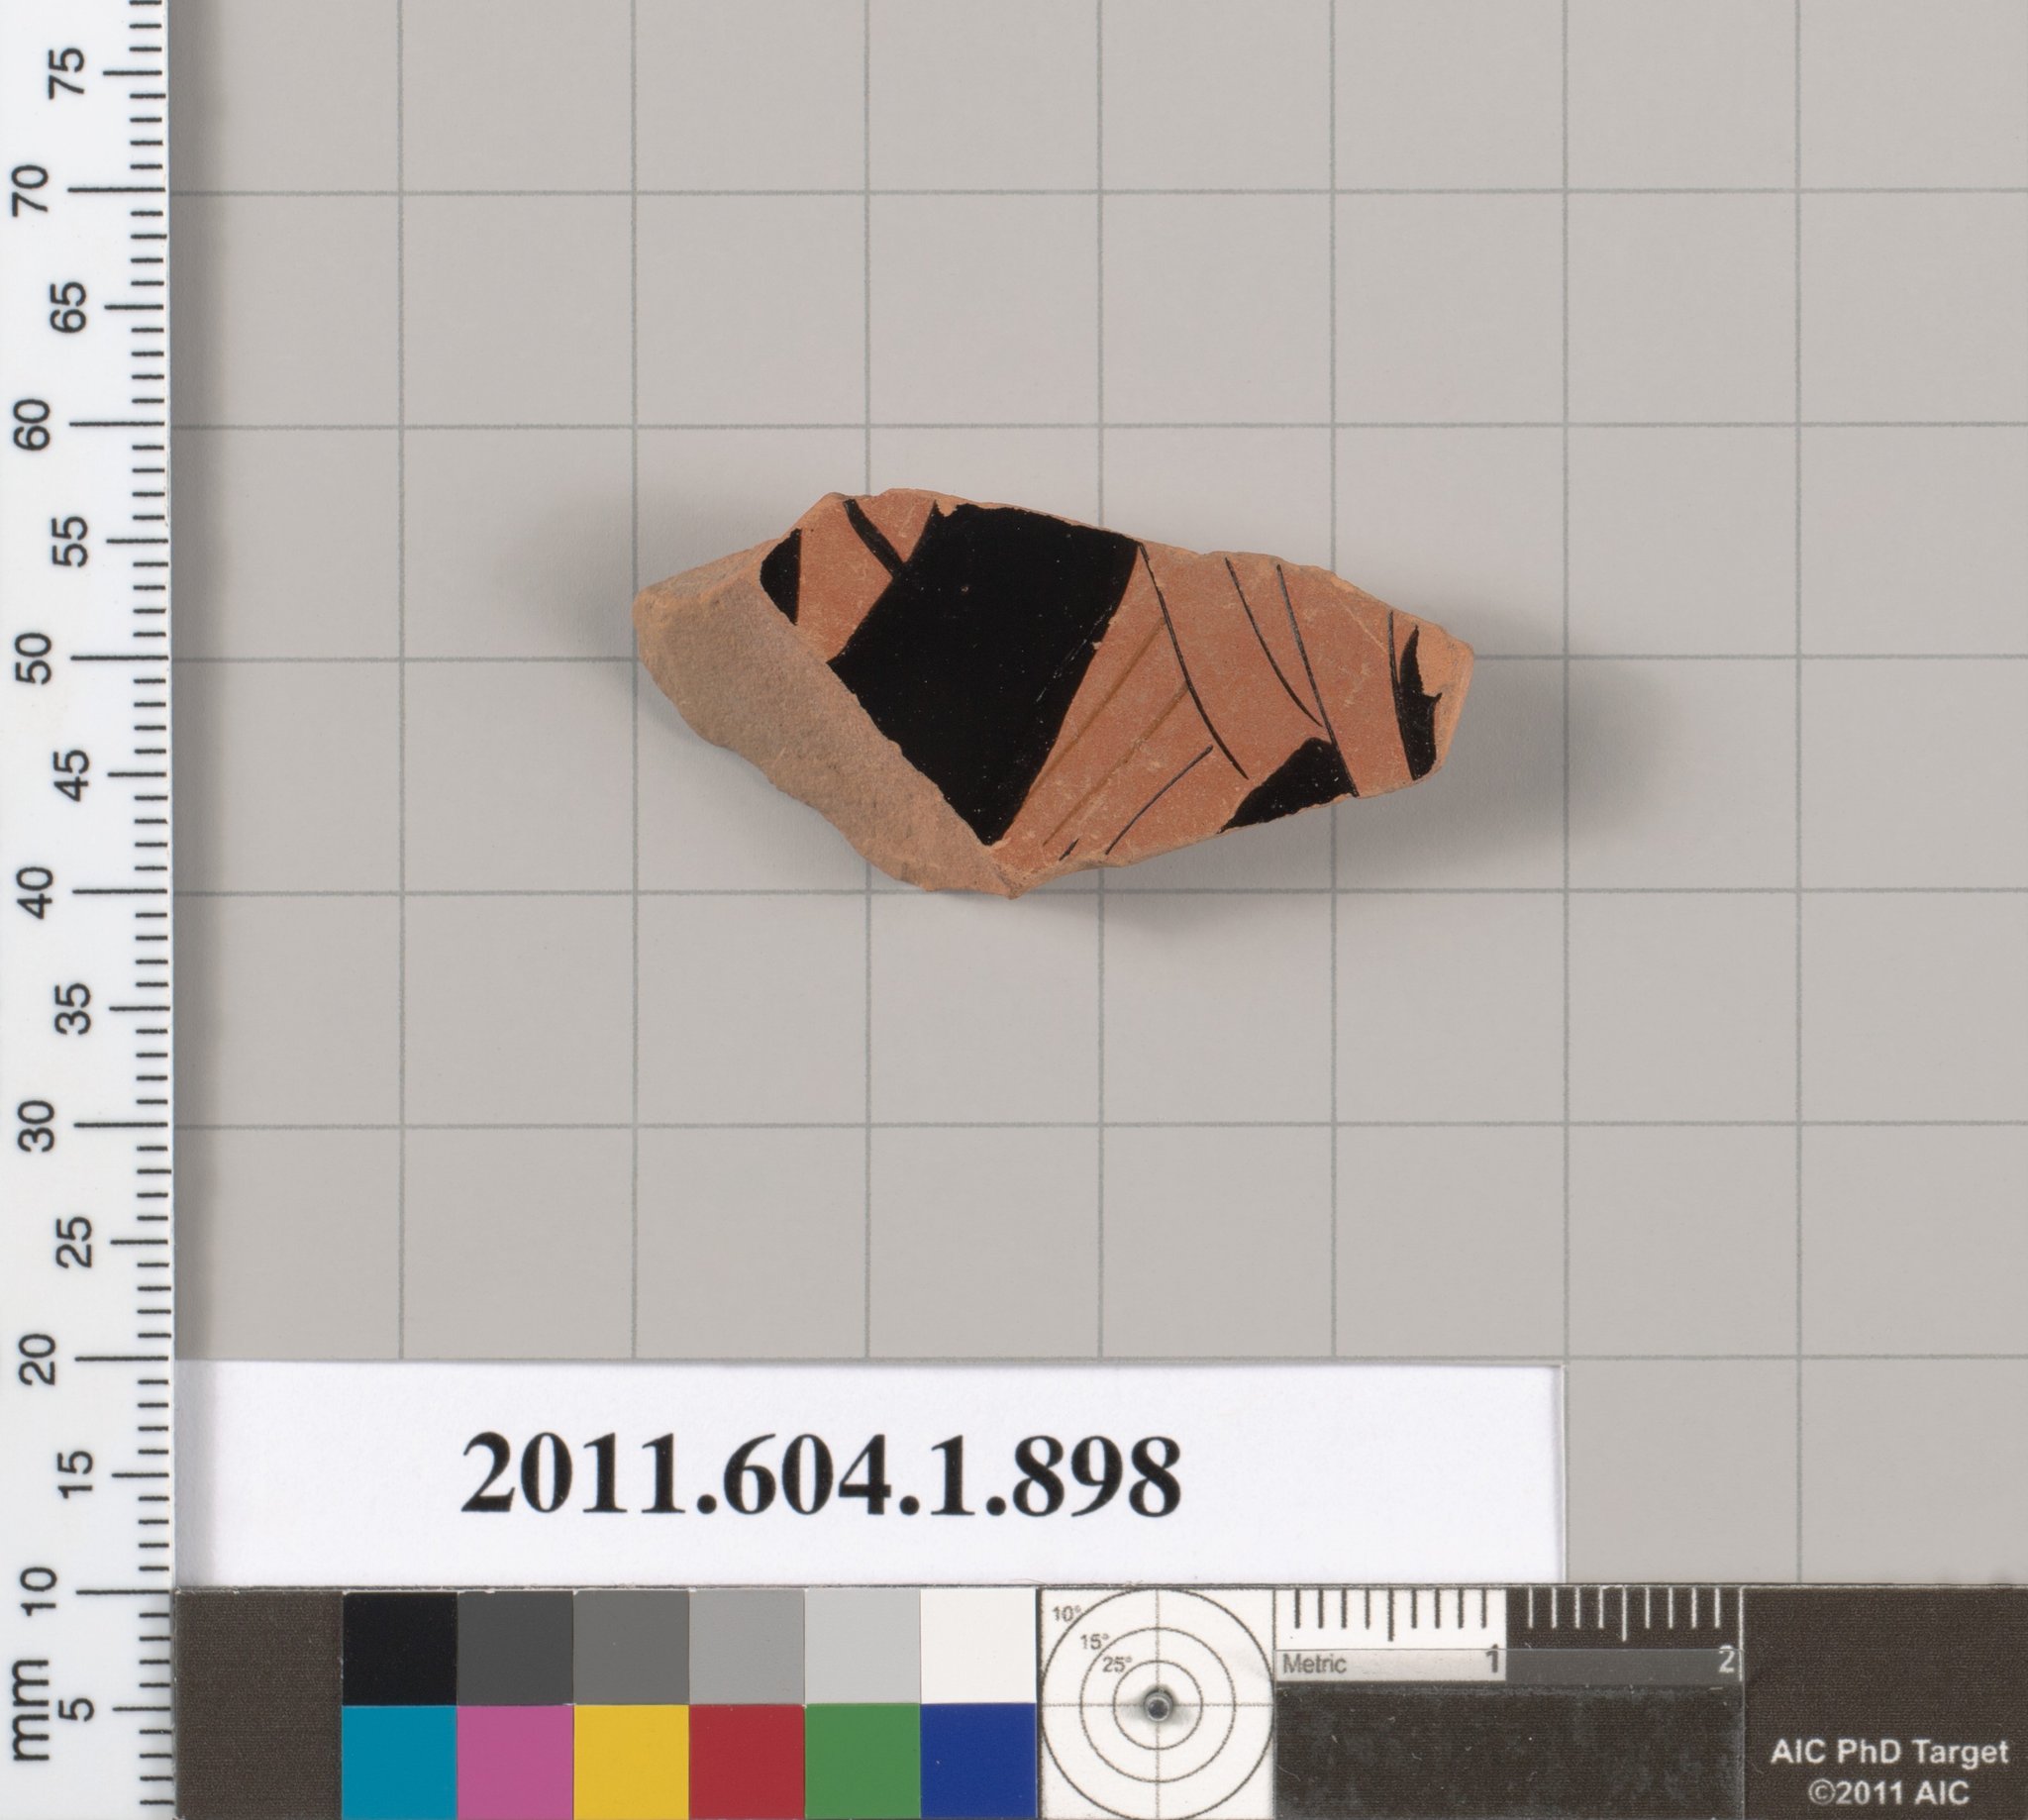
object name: kylix fragment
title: Terracotta fragment of a kylix (drinking cup)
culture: greek, attic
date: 475-451 BCE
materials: terracotta